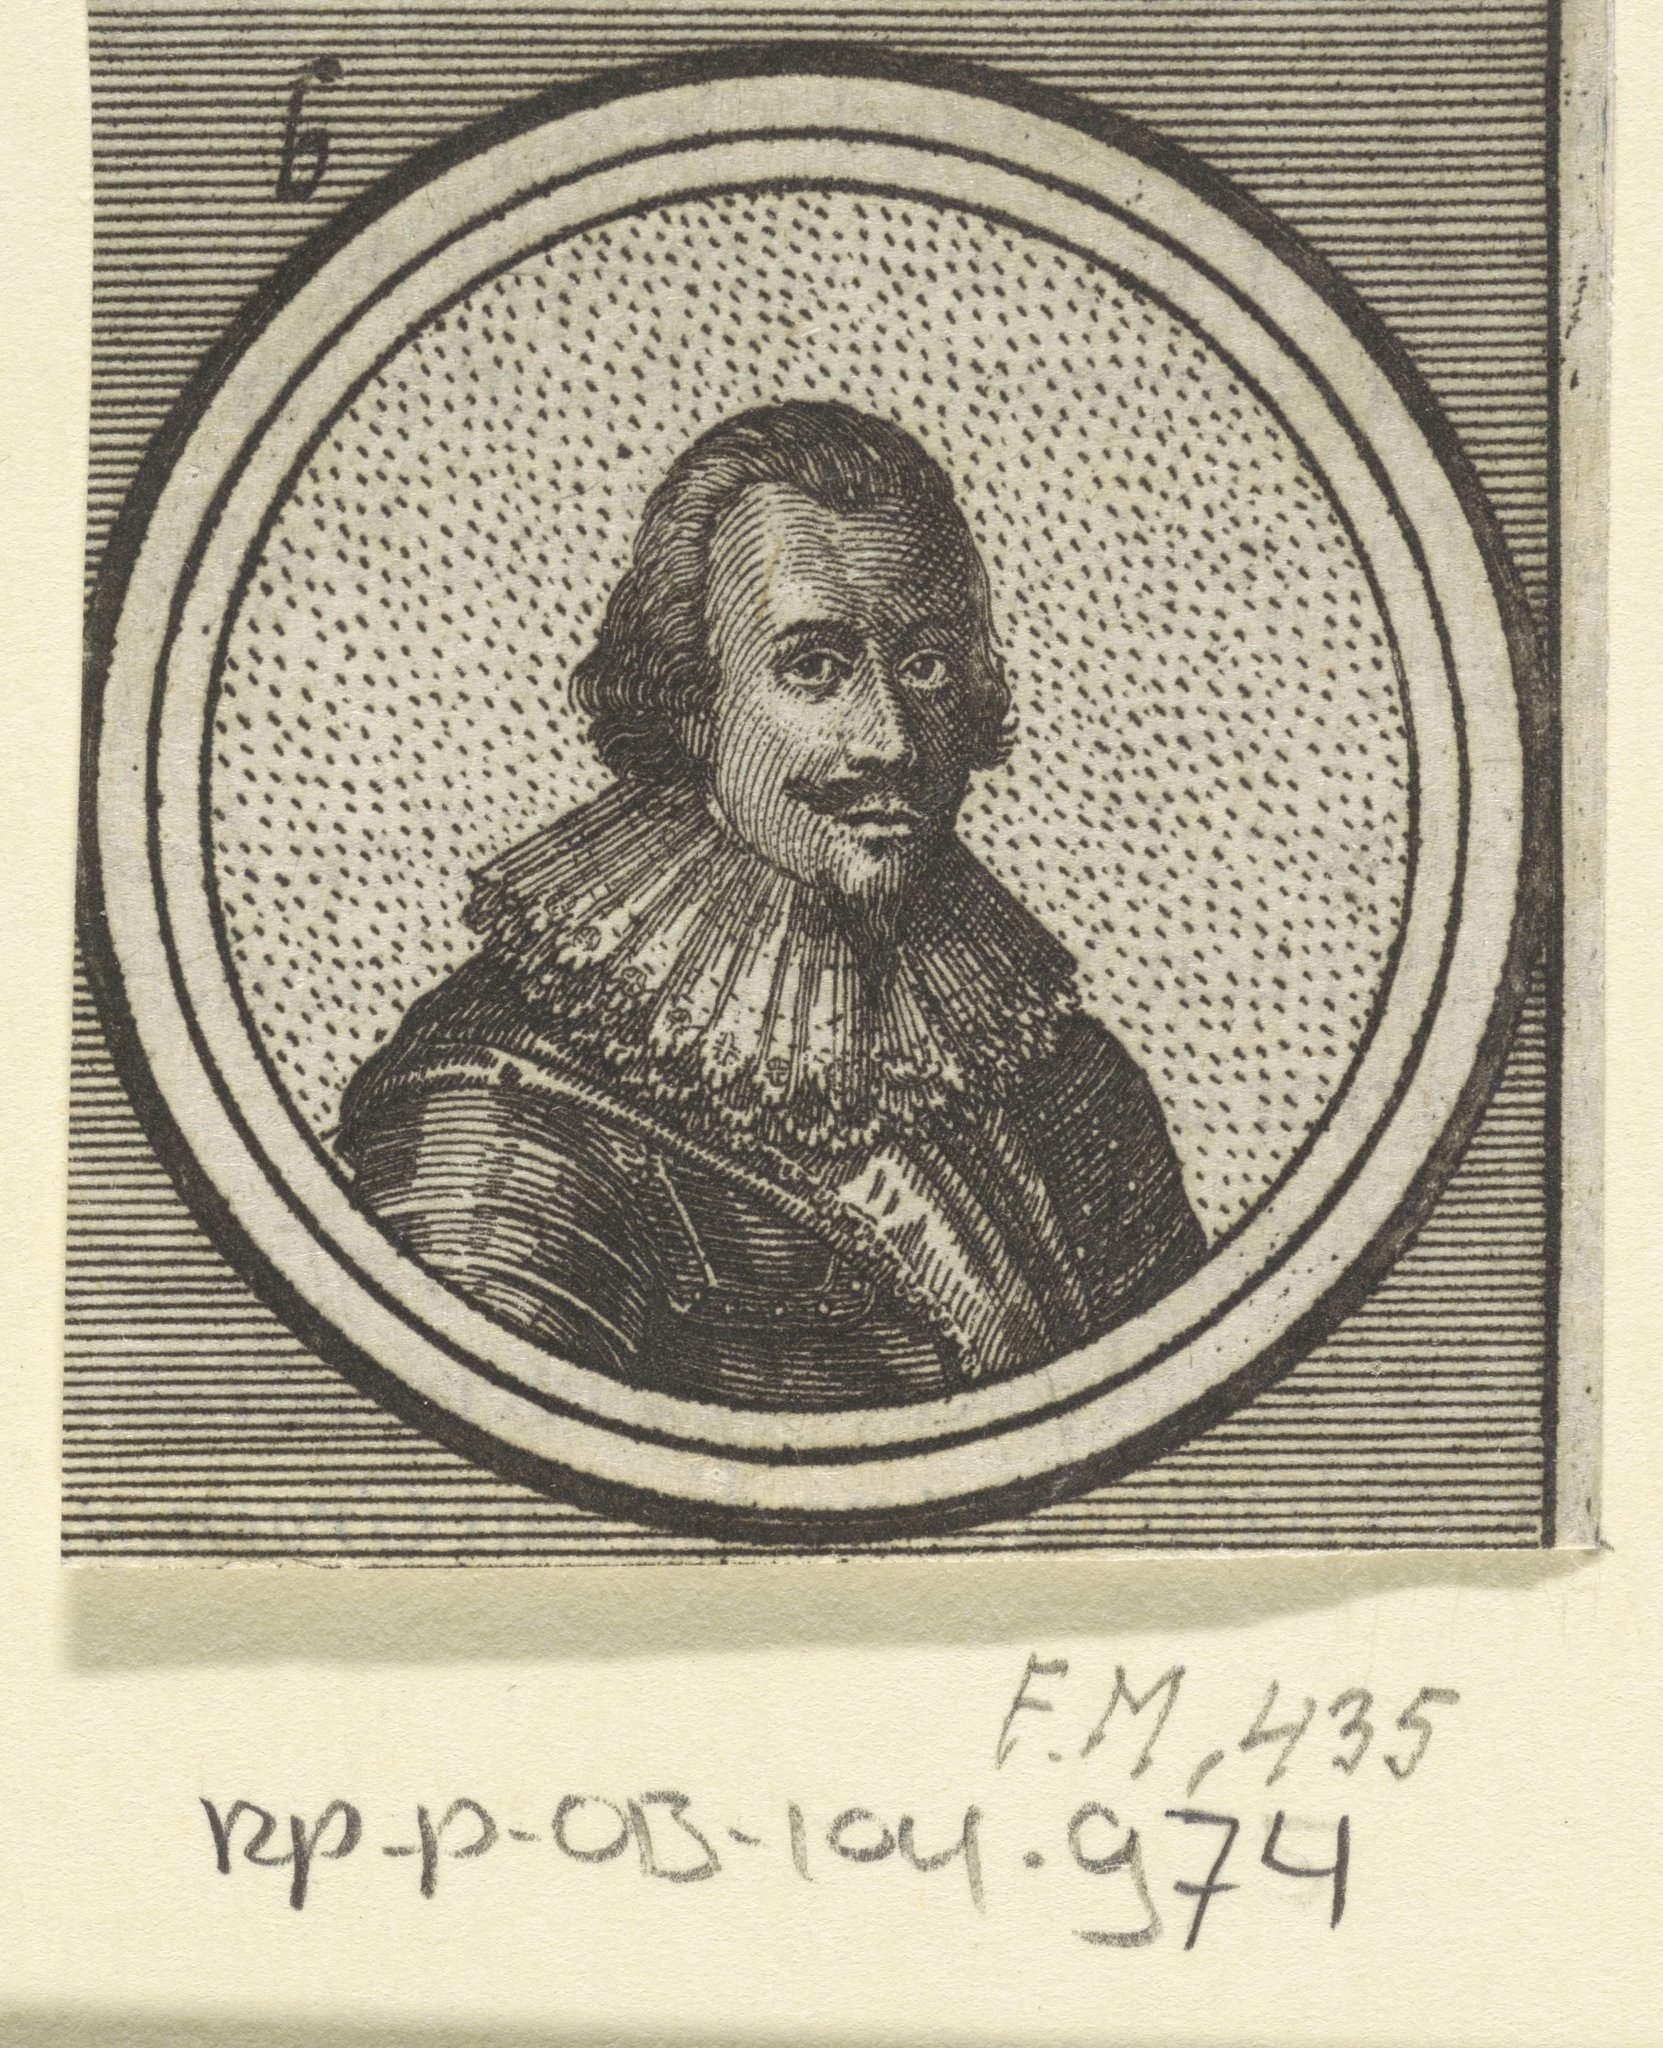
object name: print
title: Portret van Ernst Casimir, graaf van Nassau-Dietz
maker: Anonymous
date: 1600-1699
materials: paper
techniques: engraving, etching, letterpress printing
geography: low countries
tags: ernst casimir graaf van nassau-dietz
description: De hier vermelde titel verwijst naar de hoogst verkregen titel van de geportretteerde, niet per se naar de titel die de geportretteerde op deze voorstelling draagt.